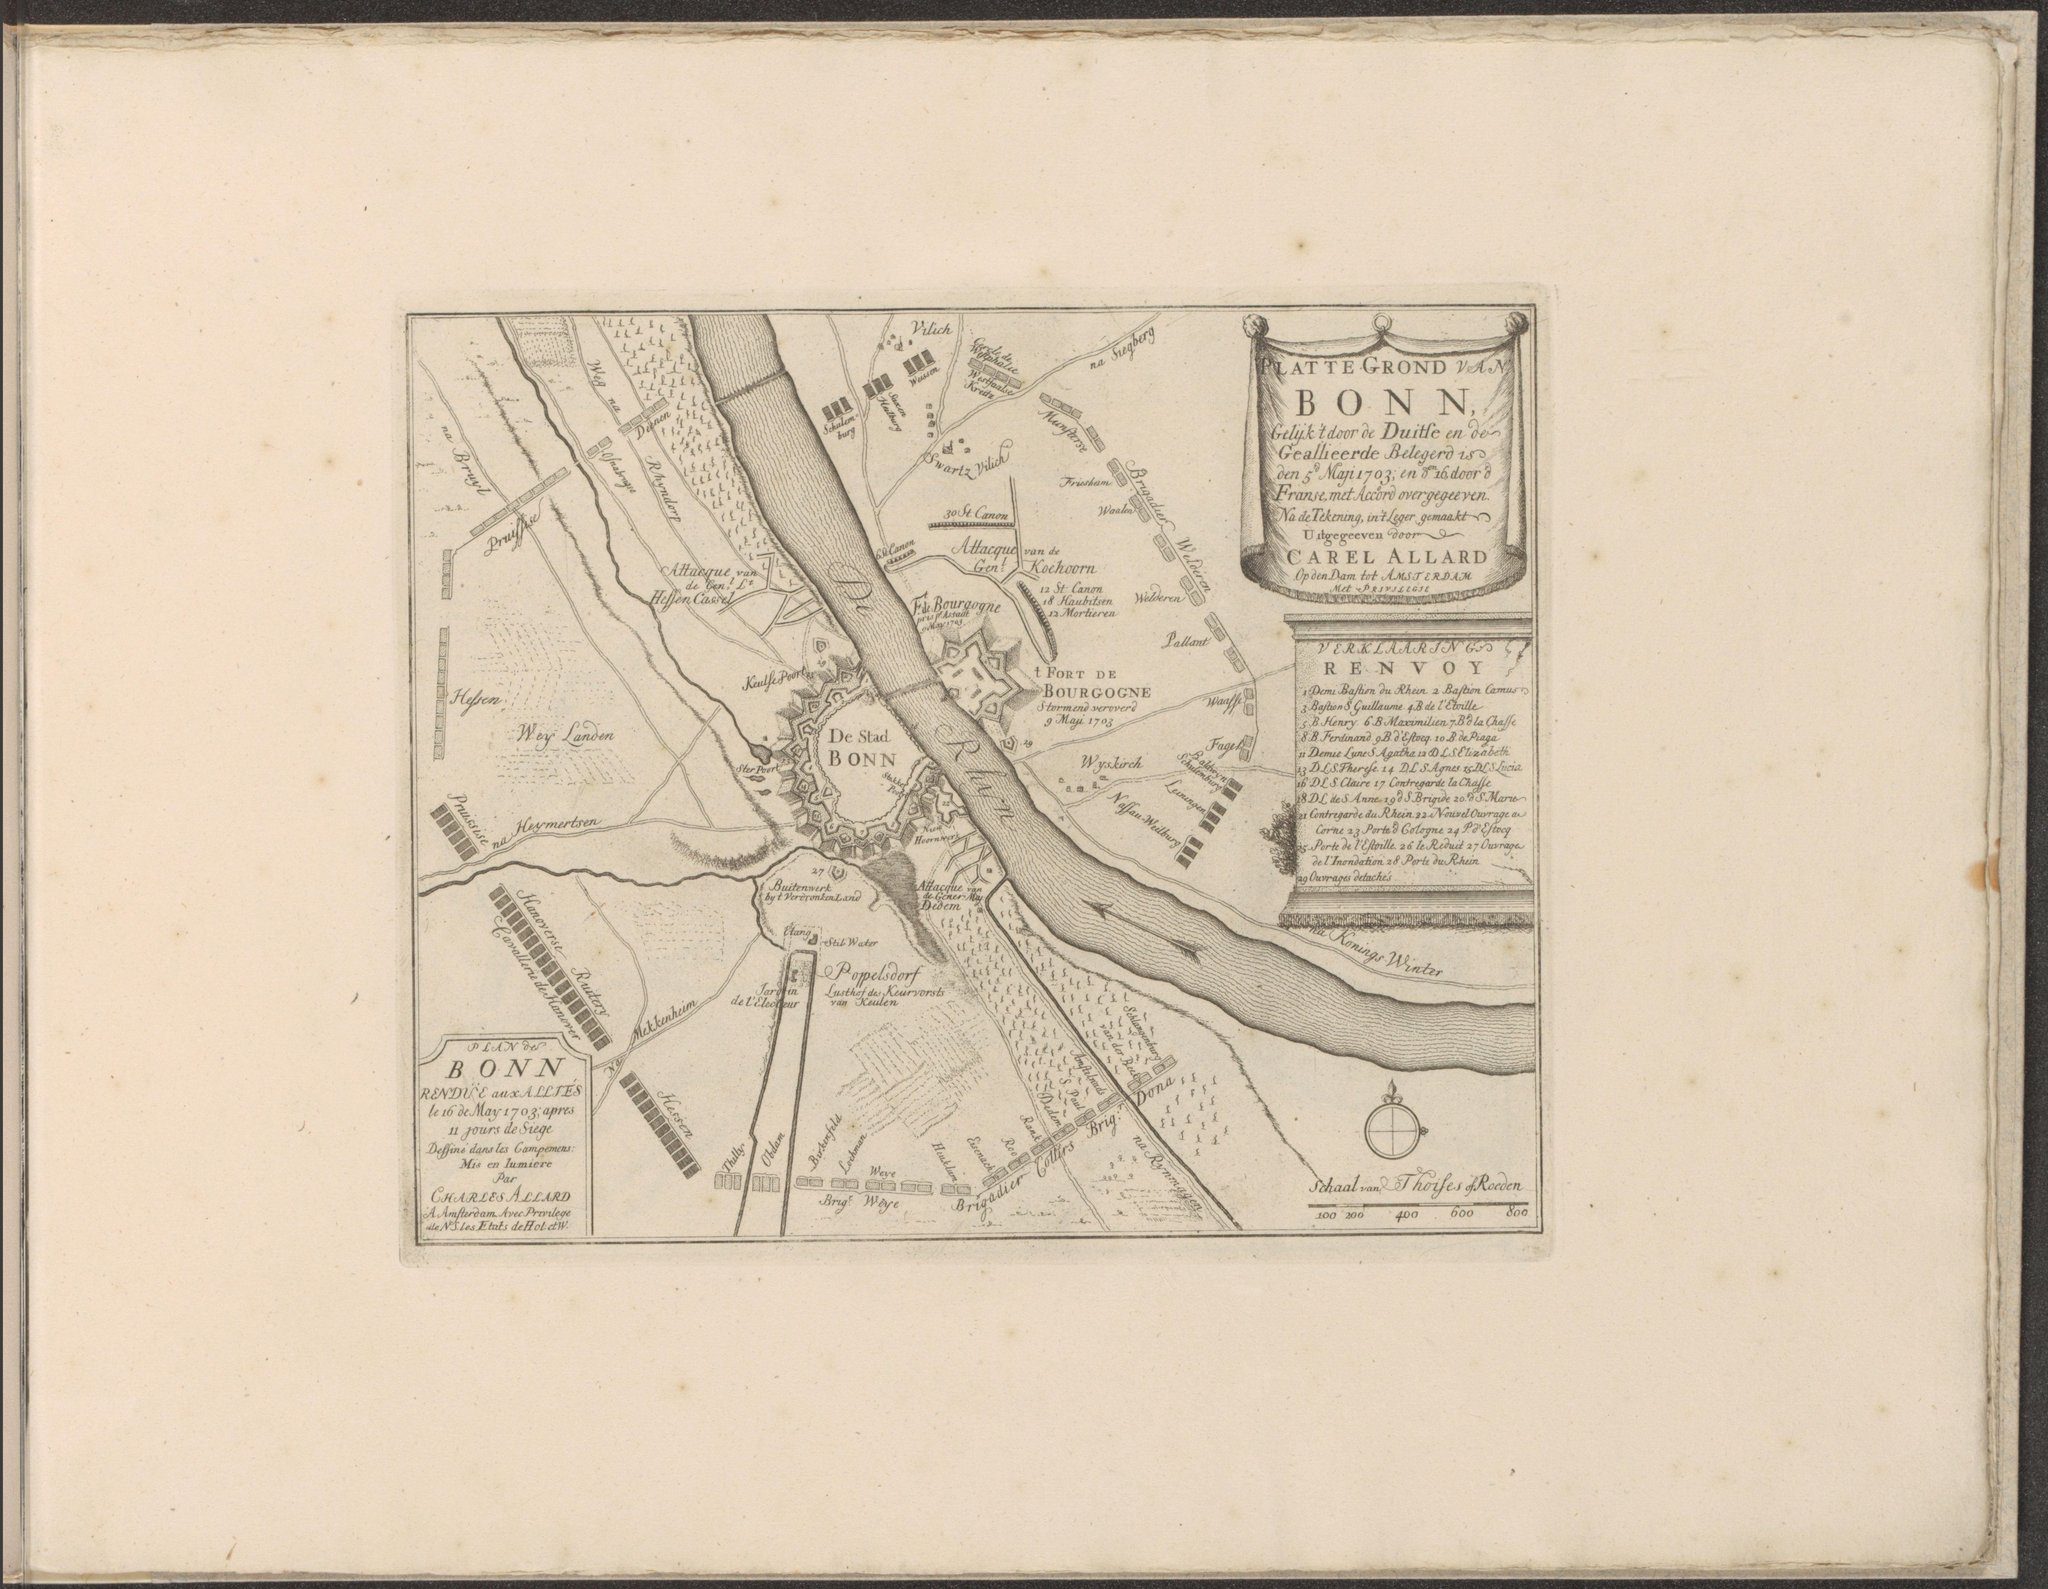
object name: album leaf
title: Beleg van Bonn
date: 1703-1733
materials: paper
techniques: etching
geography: amsterdam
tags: siege, position war, maps of cities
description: Belegering van de Duitse stad Bonn door de geallieerden vanaf 5 mei en inname na overgave door de Fransen op 15 (of 16) mei 1703. Kaart met een plattegrond van de versterkingen om de stad en de posities van de belegerende troepen. Met teksten in het Nederlands en Frans. De prent maakt deel uit van een album.